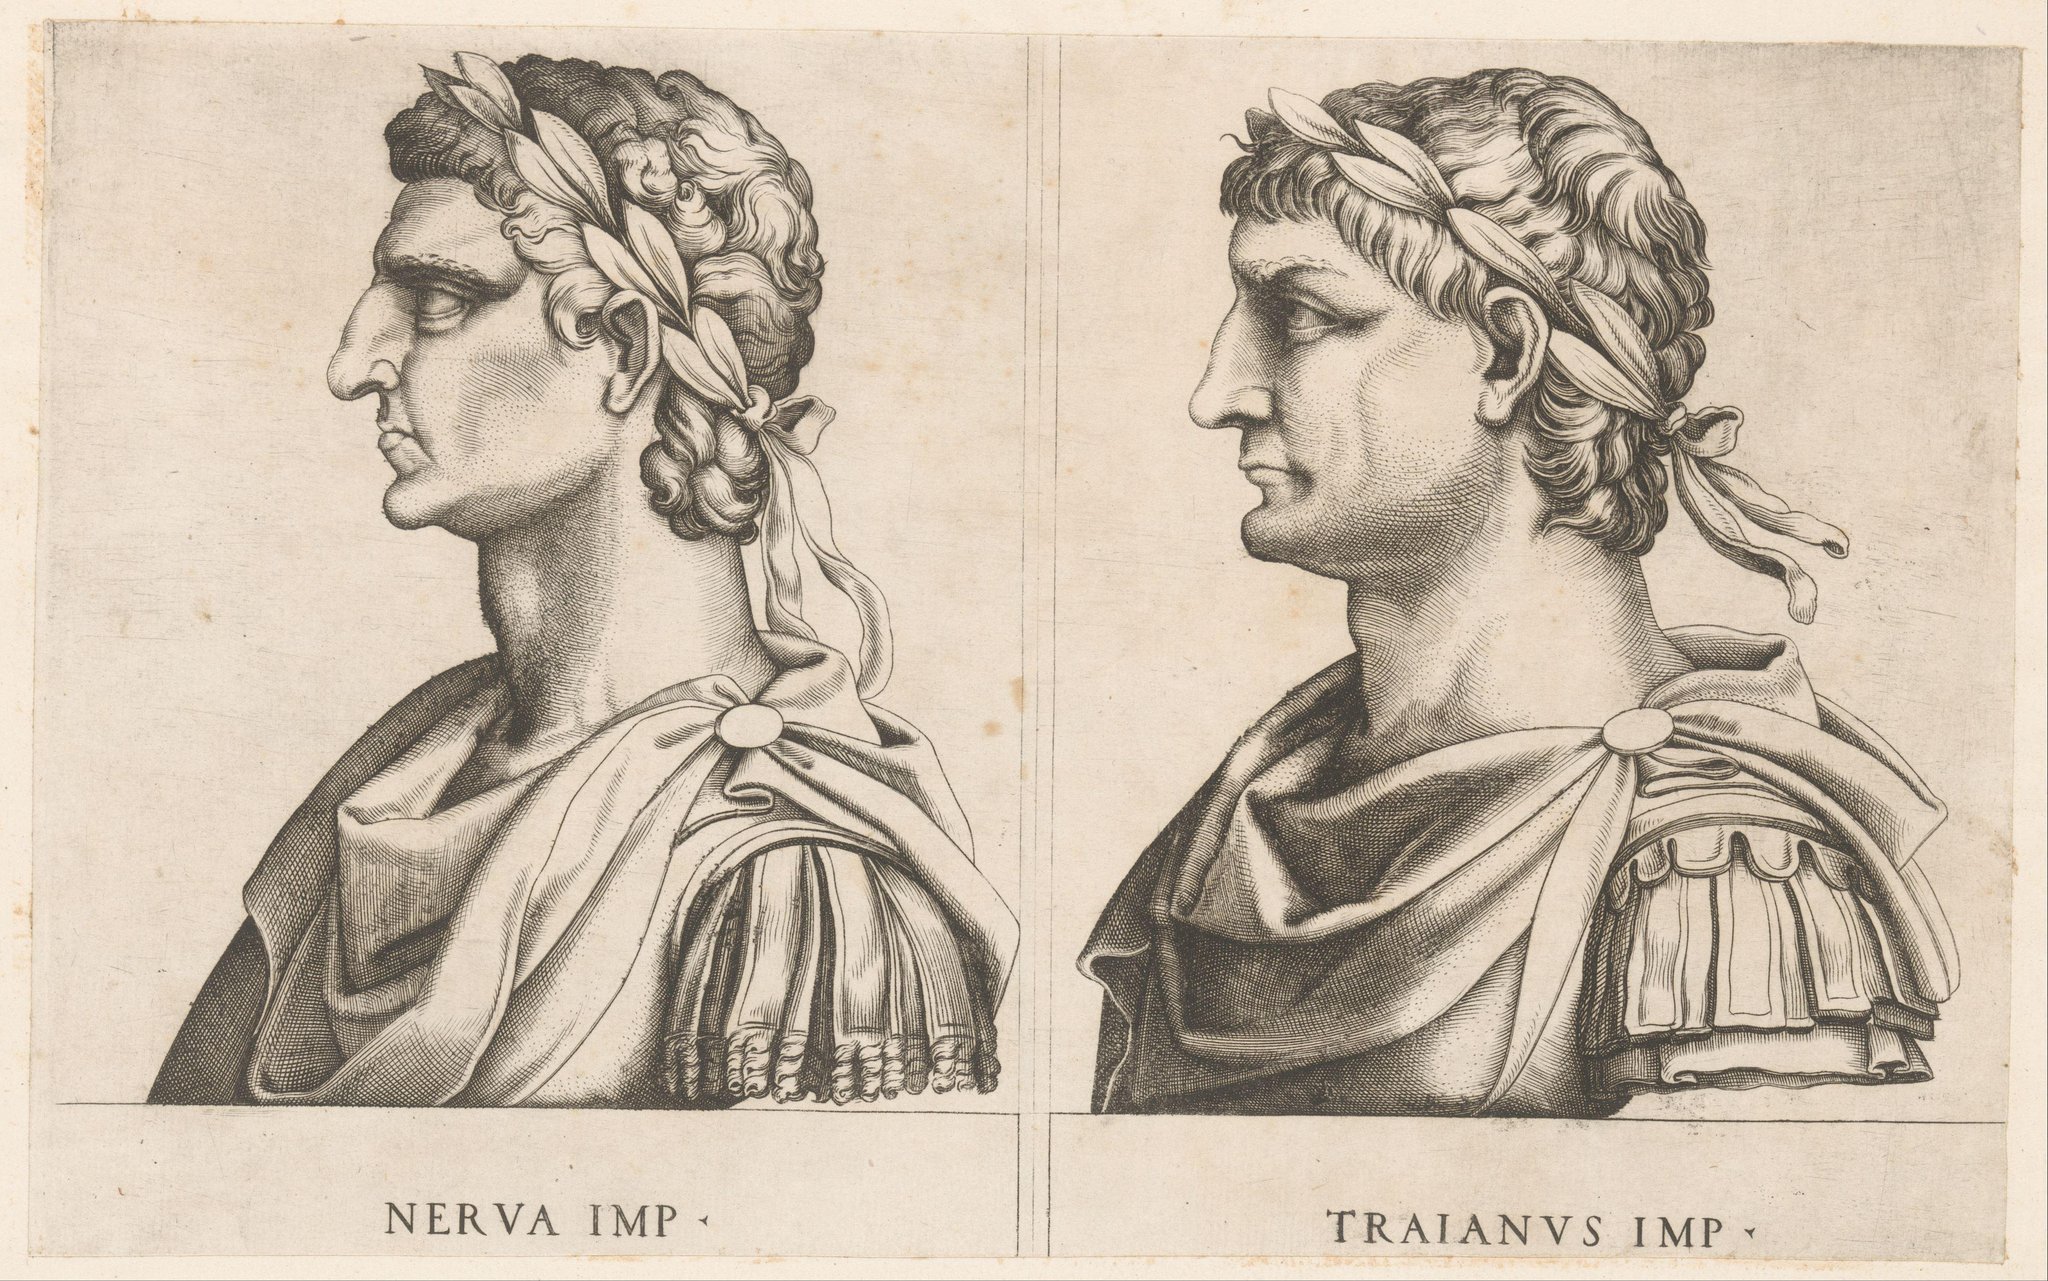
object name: print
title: Portretbustes van Romeinse keizers Nerva en Trajanus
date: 1510-1562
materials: paper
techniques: engraving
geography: rome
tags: rome, historical persons, ruler, sovereign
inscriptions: collector's mark: Lugt 11